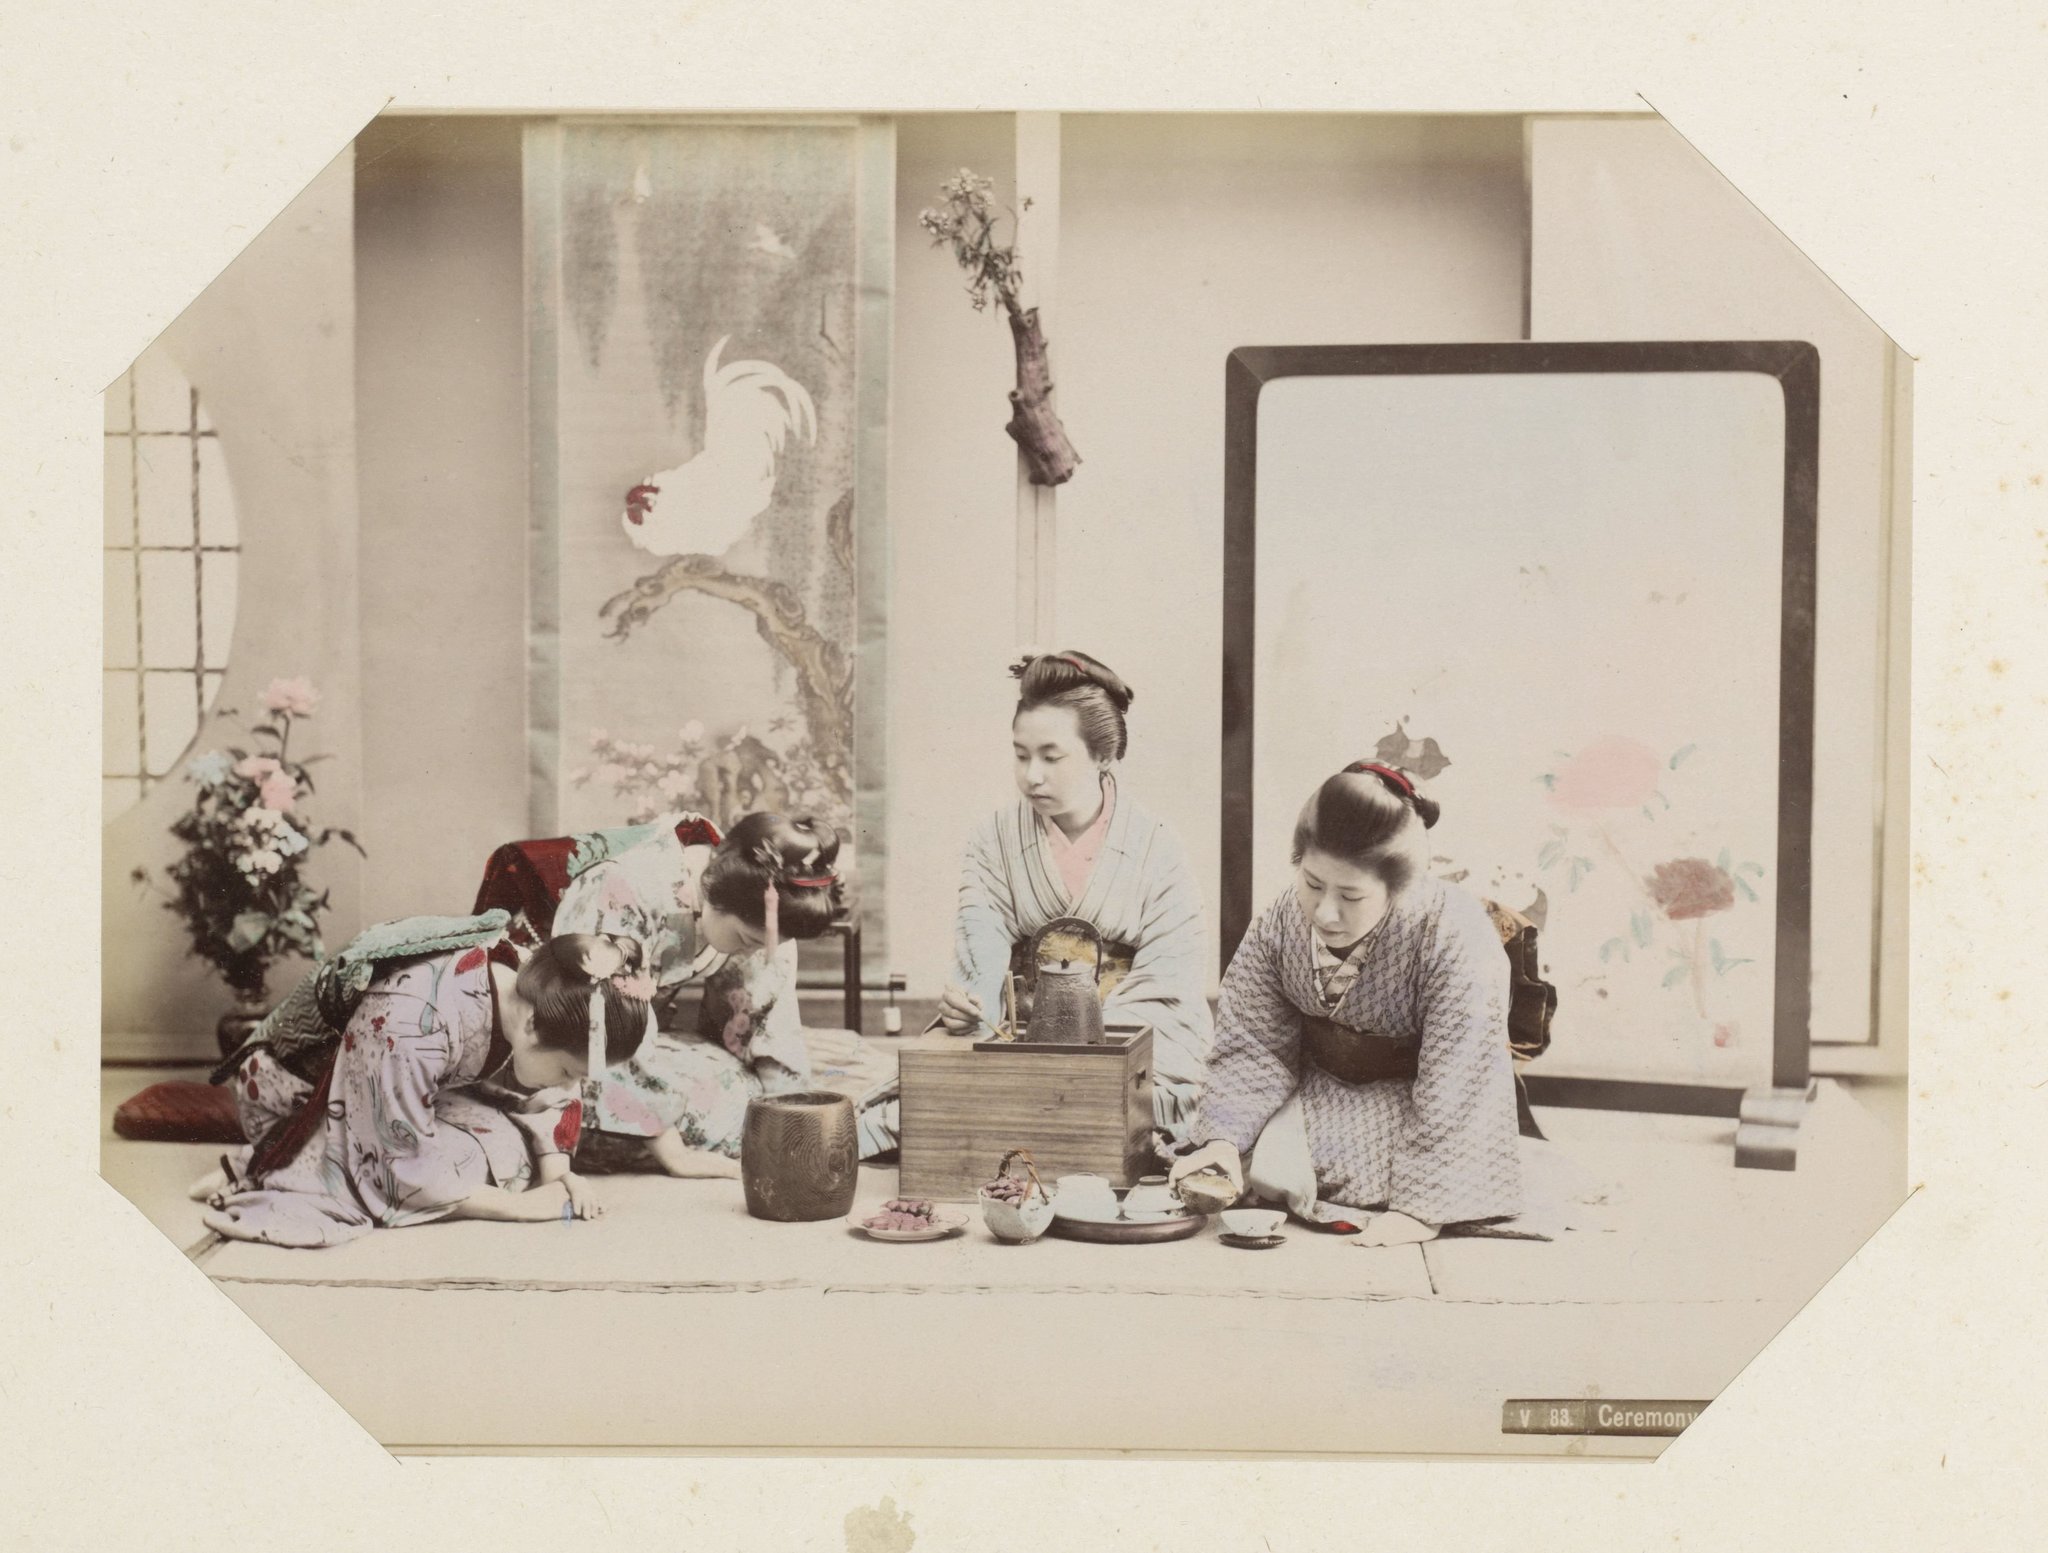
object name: photograph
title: Vier Japanse vrouwen tijdens theeceremonie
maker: Anonymous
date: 1870-1900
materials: paint, photographic support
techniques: albumen print, hand coloring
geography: japan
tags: adult woman, screen, folding screen, tea- and coffee-service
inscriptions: number: ‘V 83’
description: Onderdeel van Fotoalbum met opnames van bezienswaardigheden in Japan en studioportretten.